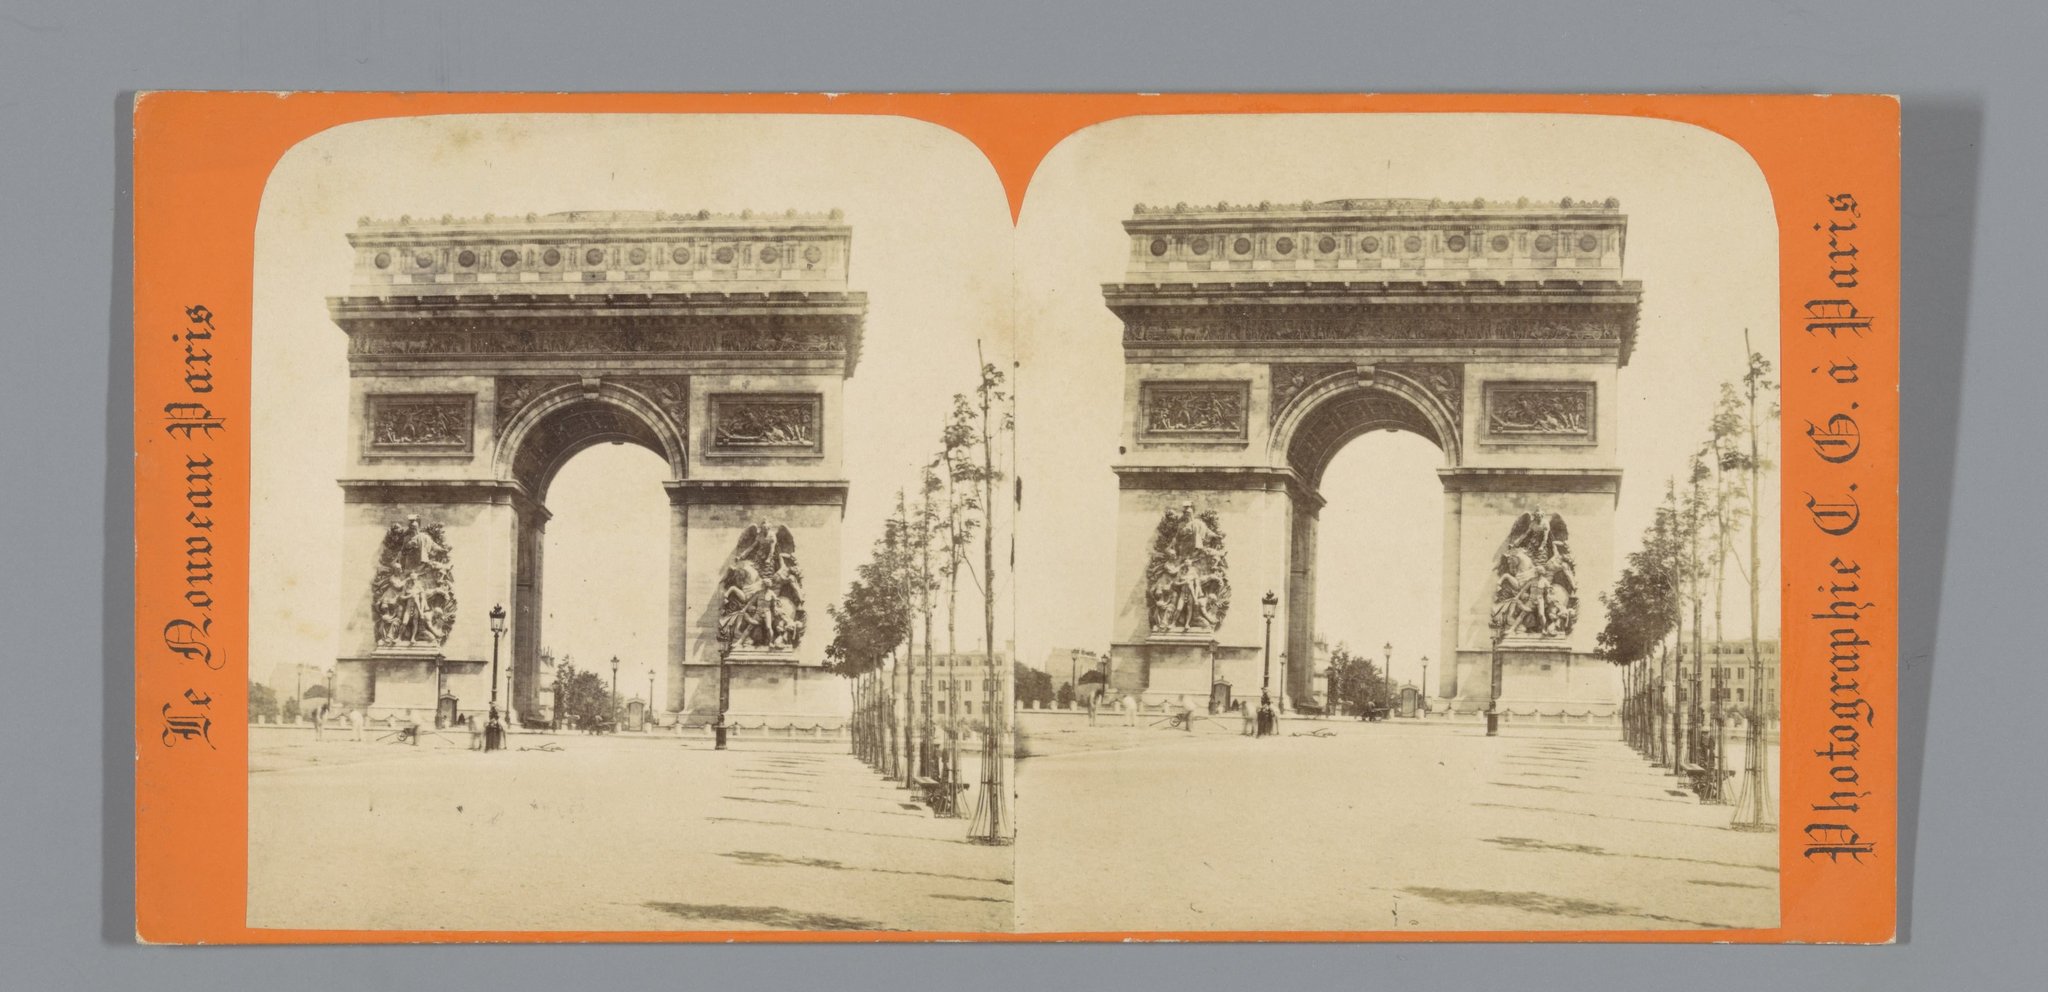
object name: stereograph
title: Le Nouveau Paris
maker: charles gérard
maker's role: fotograaf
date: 1860-1870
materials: cardboard, photographic support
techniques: albumen print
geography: paris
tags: triumphal arch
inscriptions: inscription: ‘Arc de l'etoile’, inscription: ‘Photographie C. G. à Paris.’